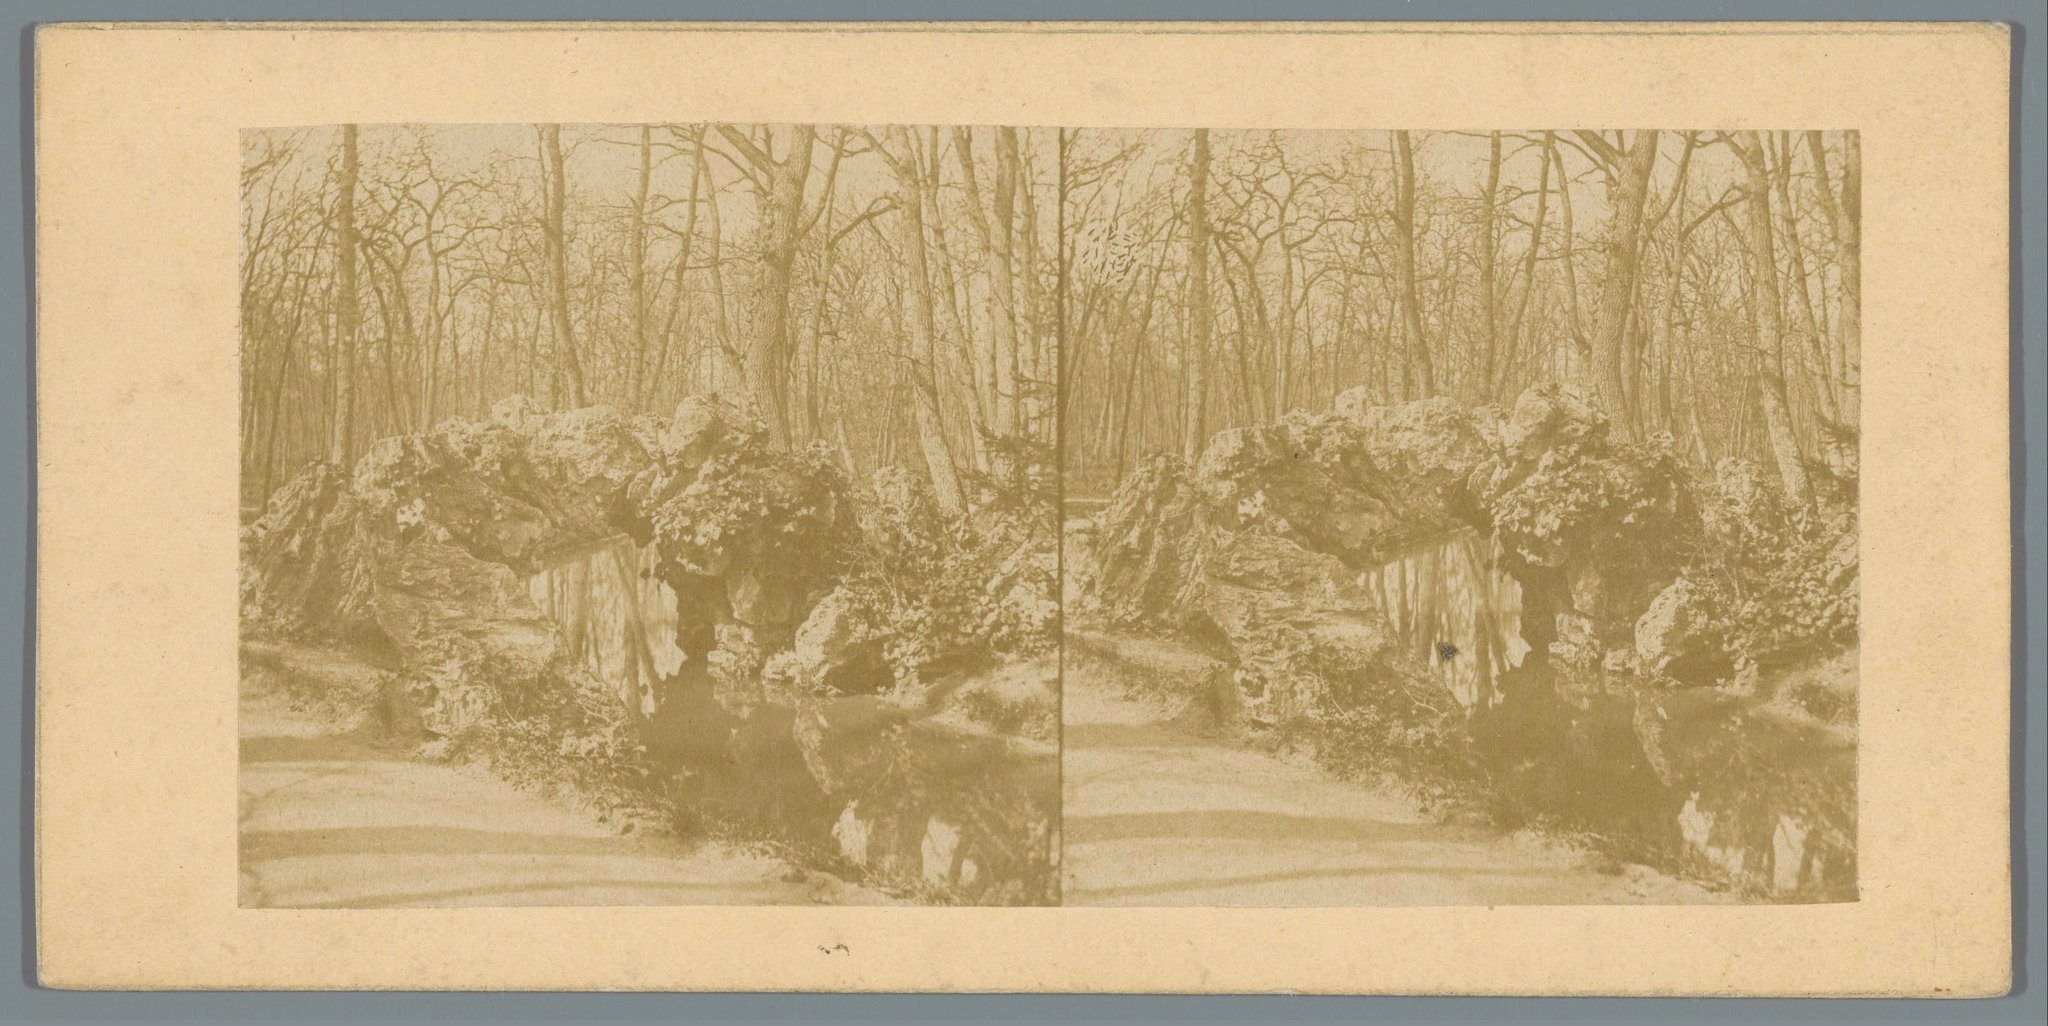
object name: stereograph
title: Gezicht op een stenen brug in het Bois de Boulogne in Parijs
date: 1850-1880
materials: cardboard, photographic support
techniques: albumen print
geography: paris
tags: bridge, public gardens, park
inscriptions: inscription: ‘Bois de Boulogne’